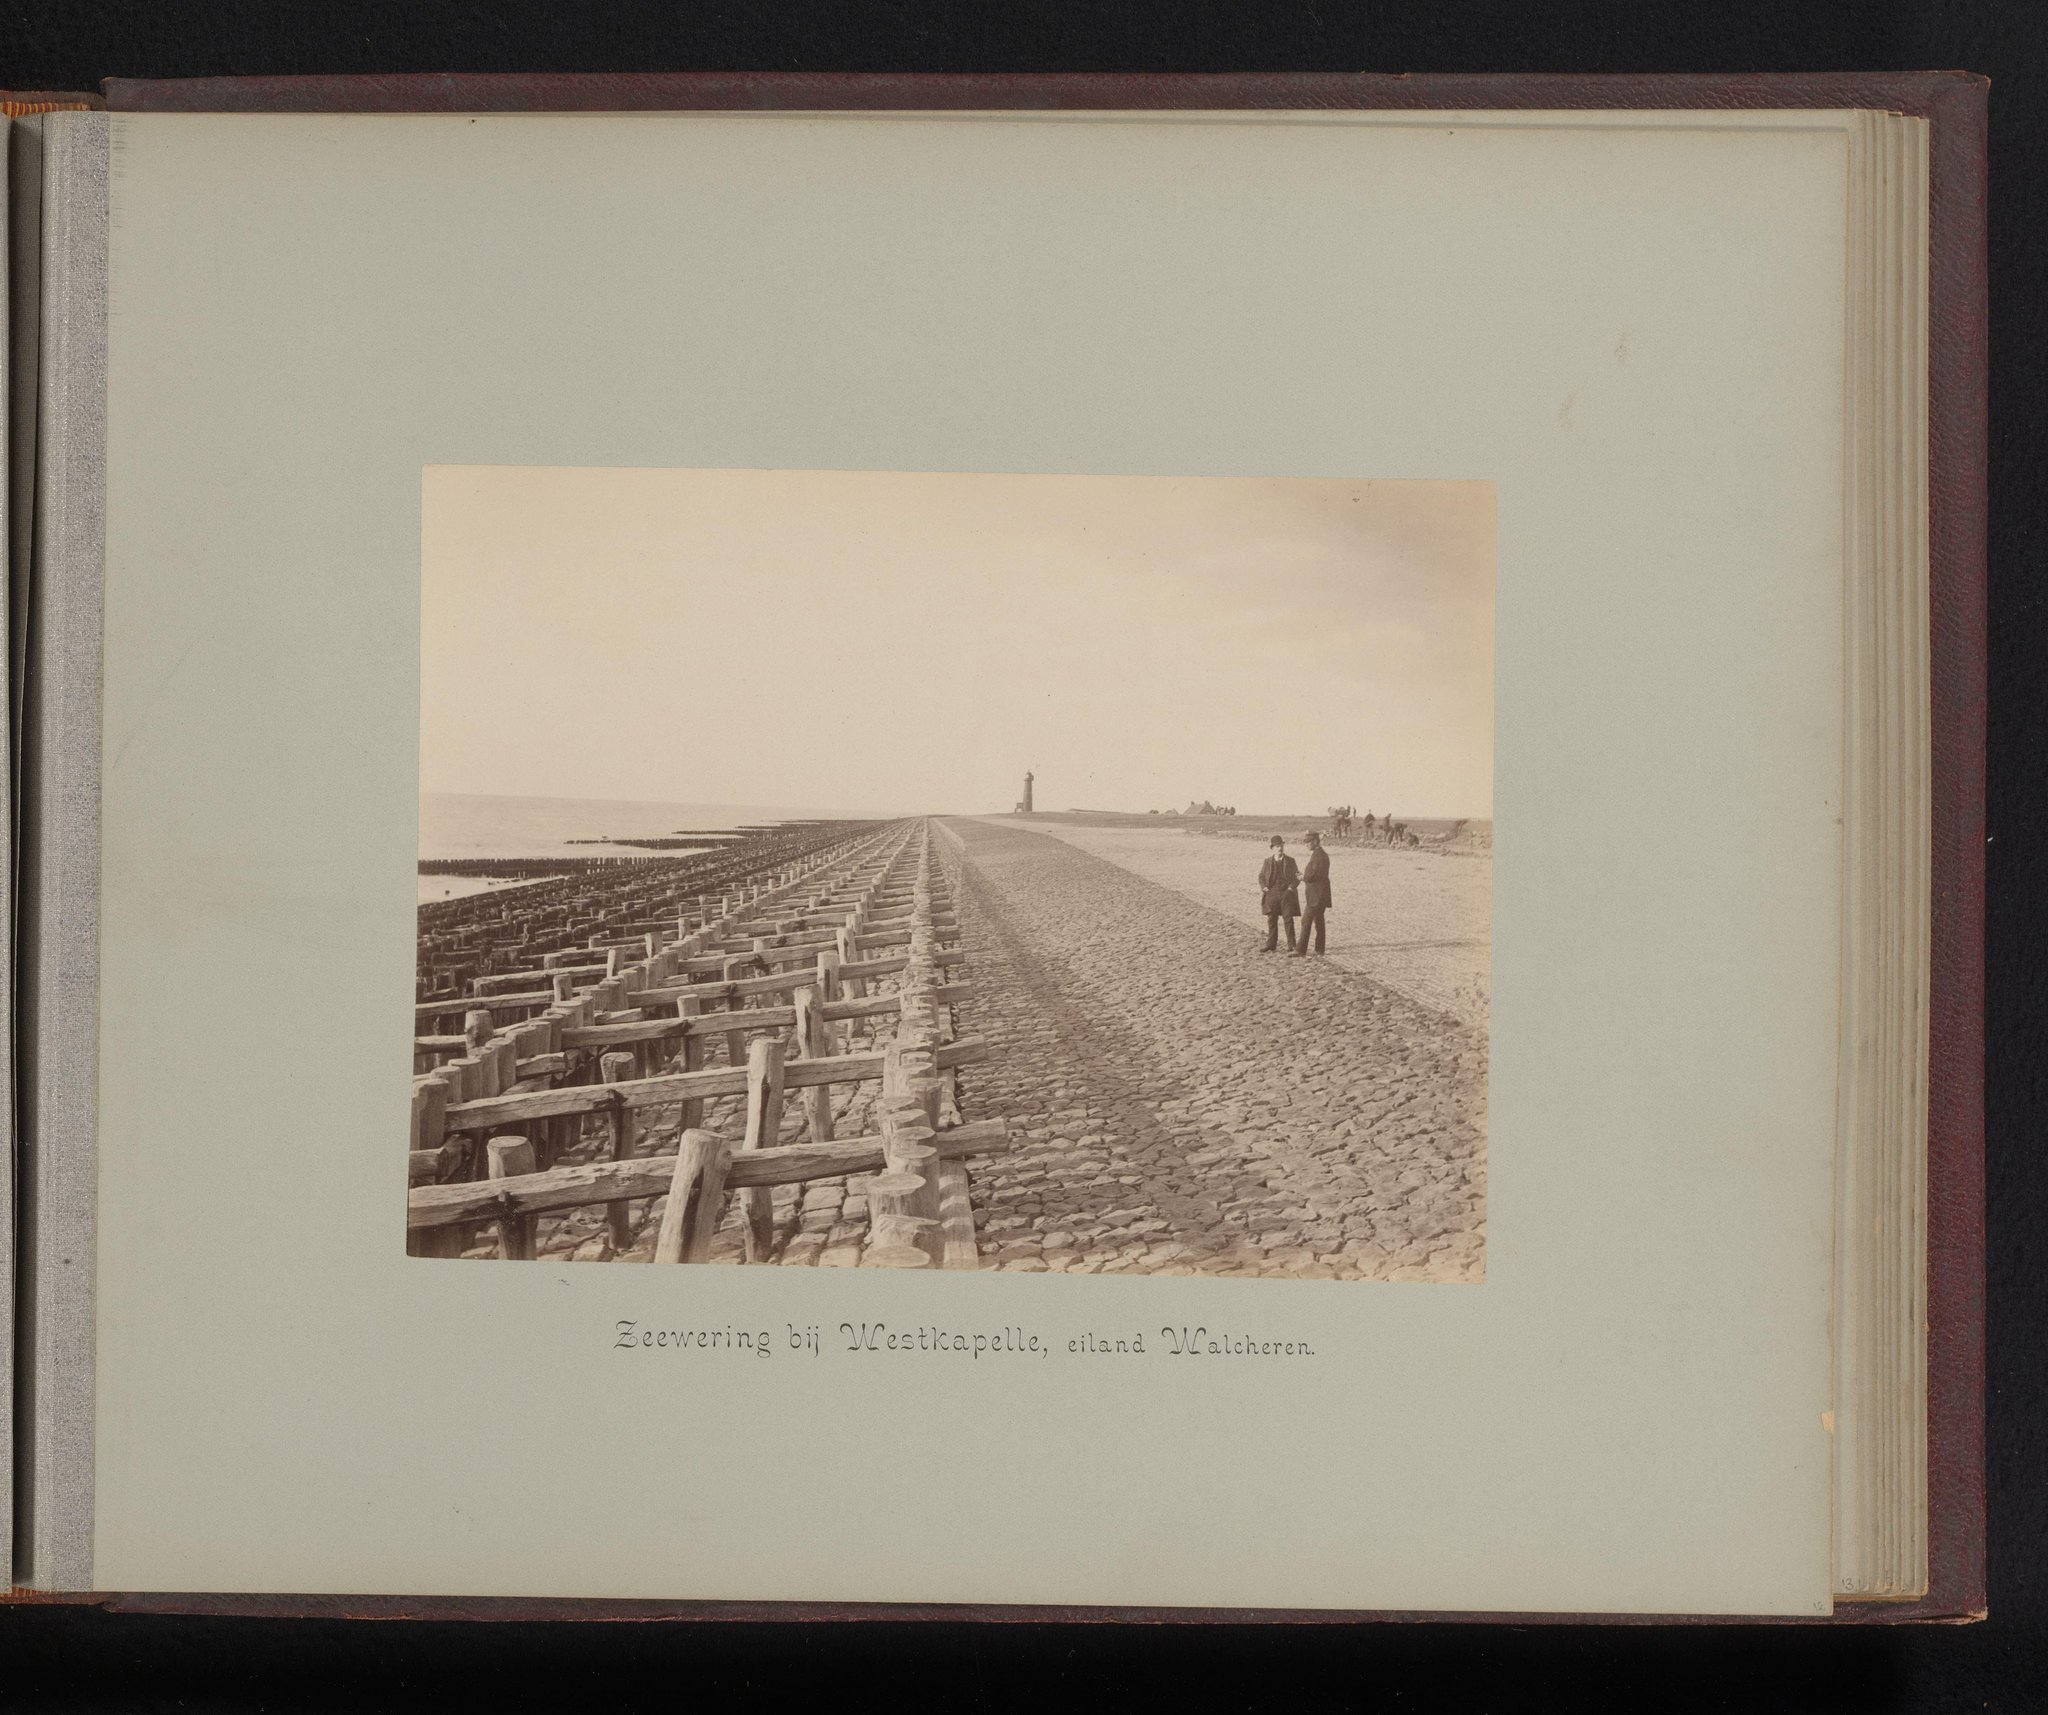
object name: album leaf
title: Gezicht op een zeewering bij Westkapelle op Walcheren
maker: carl emil mögle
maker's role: fotograaf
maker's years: 1857-1934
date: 1883-1900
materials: cardboard, photographic support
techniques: albumen print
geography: westkapelle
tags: dikes, levee, sea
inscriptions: inscription: ‘C. E. MÖGLE/ PHOTOGRAAF/ ROTTERDAM’